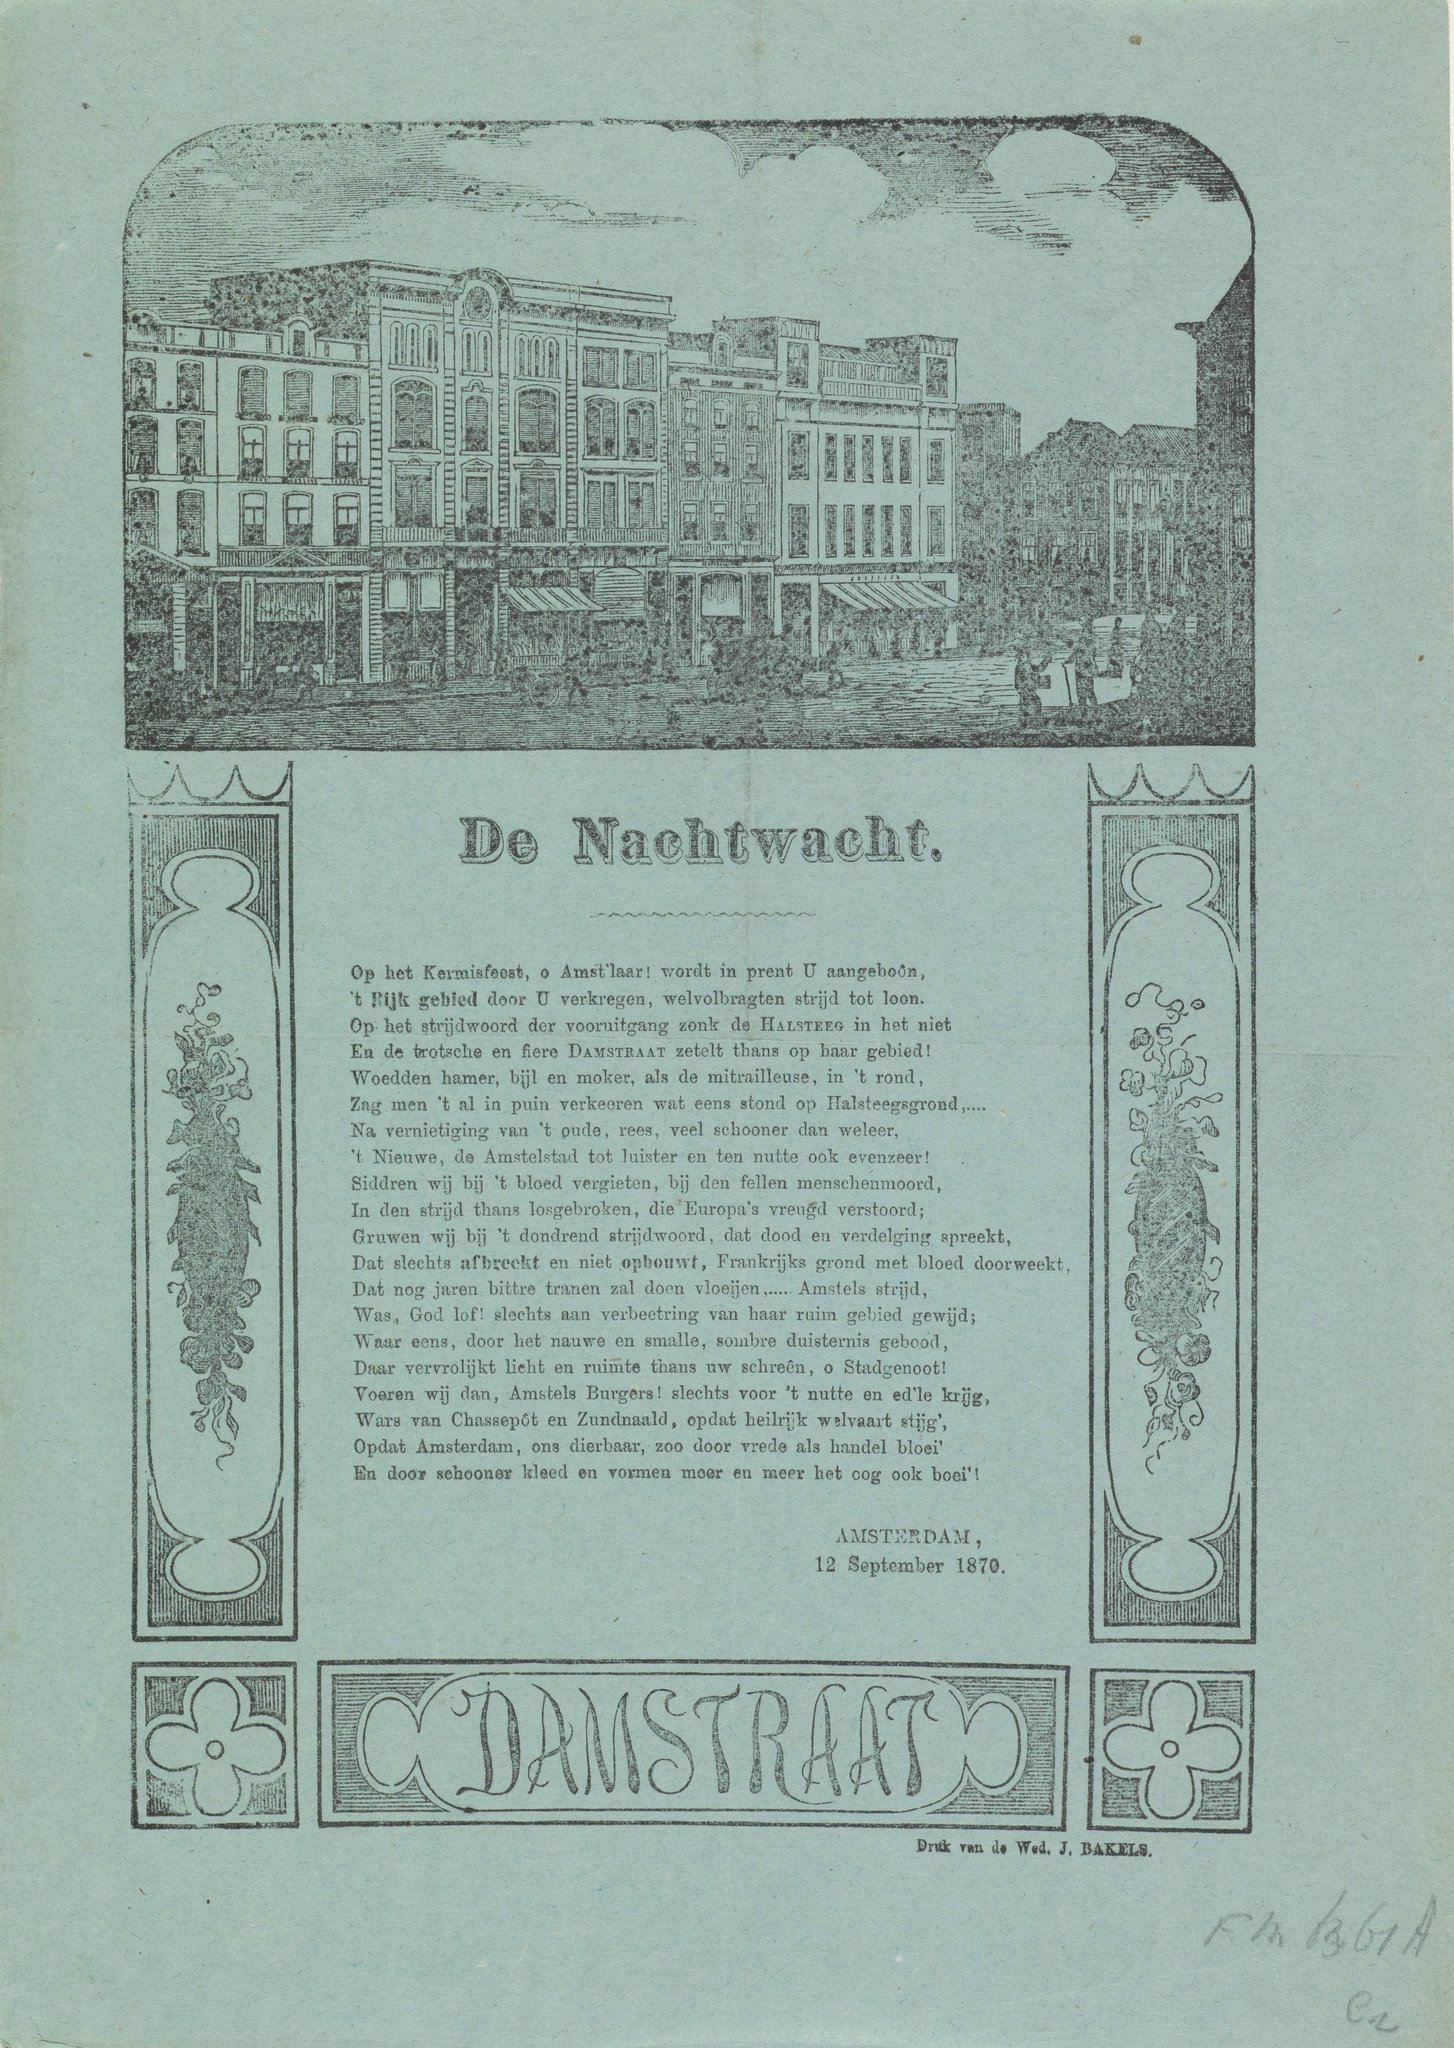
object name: print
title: Kermisprent van de Amsterdamse nachtwacht voor het jaar 1870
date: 1870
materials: paper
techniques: letterpress printing, engraving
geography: amsterdam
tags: night patrol, street, amsterdam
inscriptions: collector's mark: Lugt 2228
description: Kermisprent van de Amsterdamse nachtwacht (ratelwacht), 12 september 1870. Centraal een gedicht, daarboven een gezicht in de Damstraat.